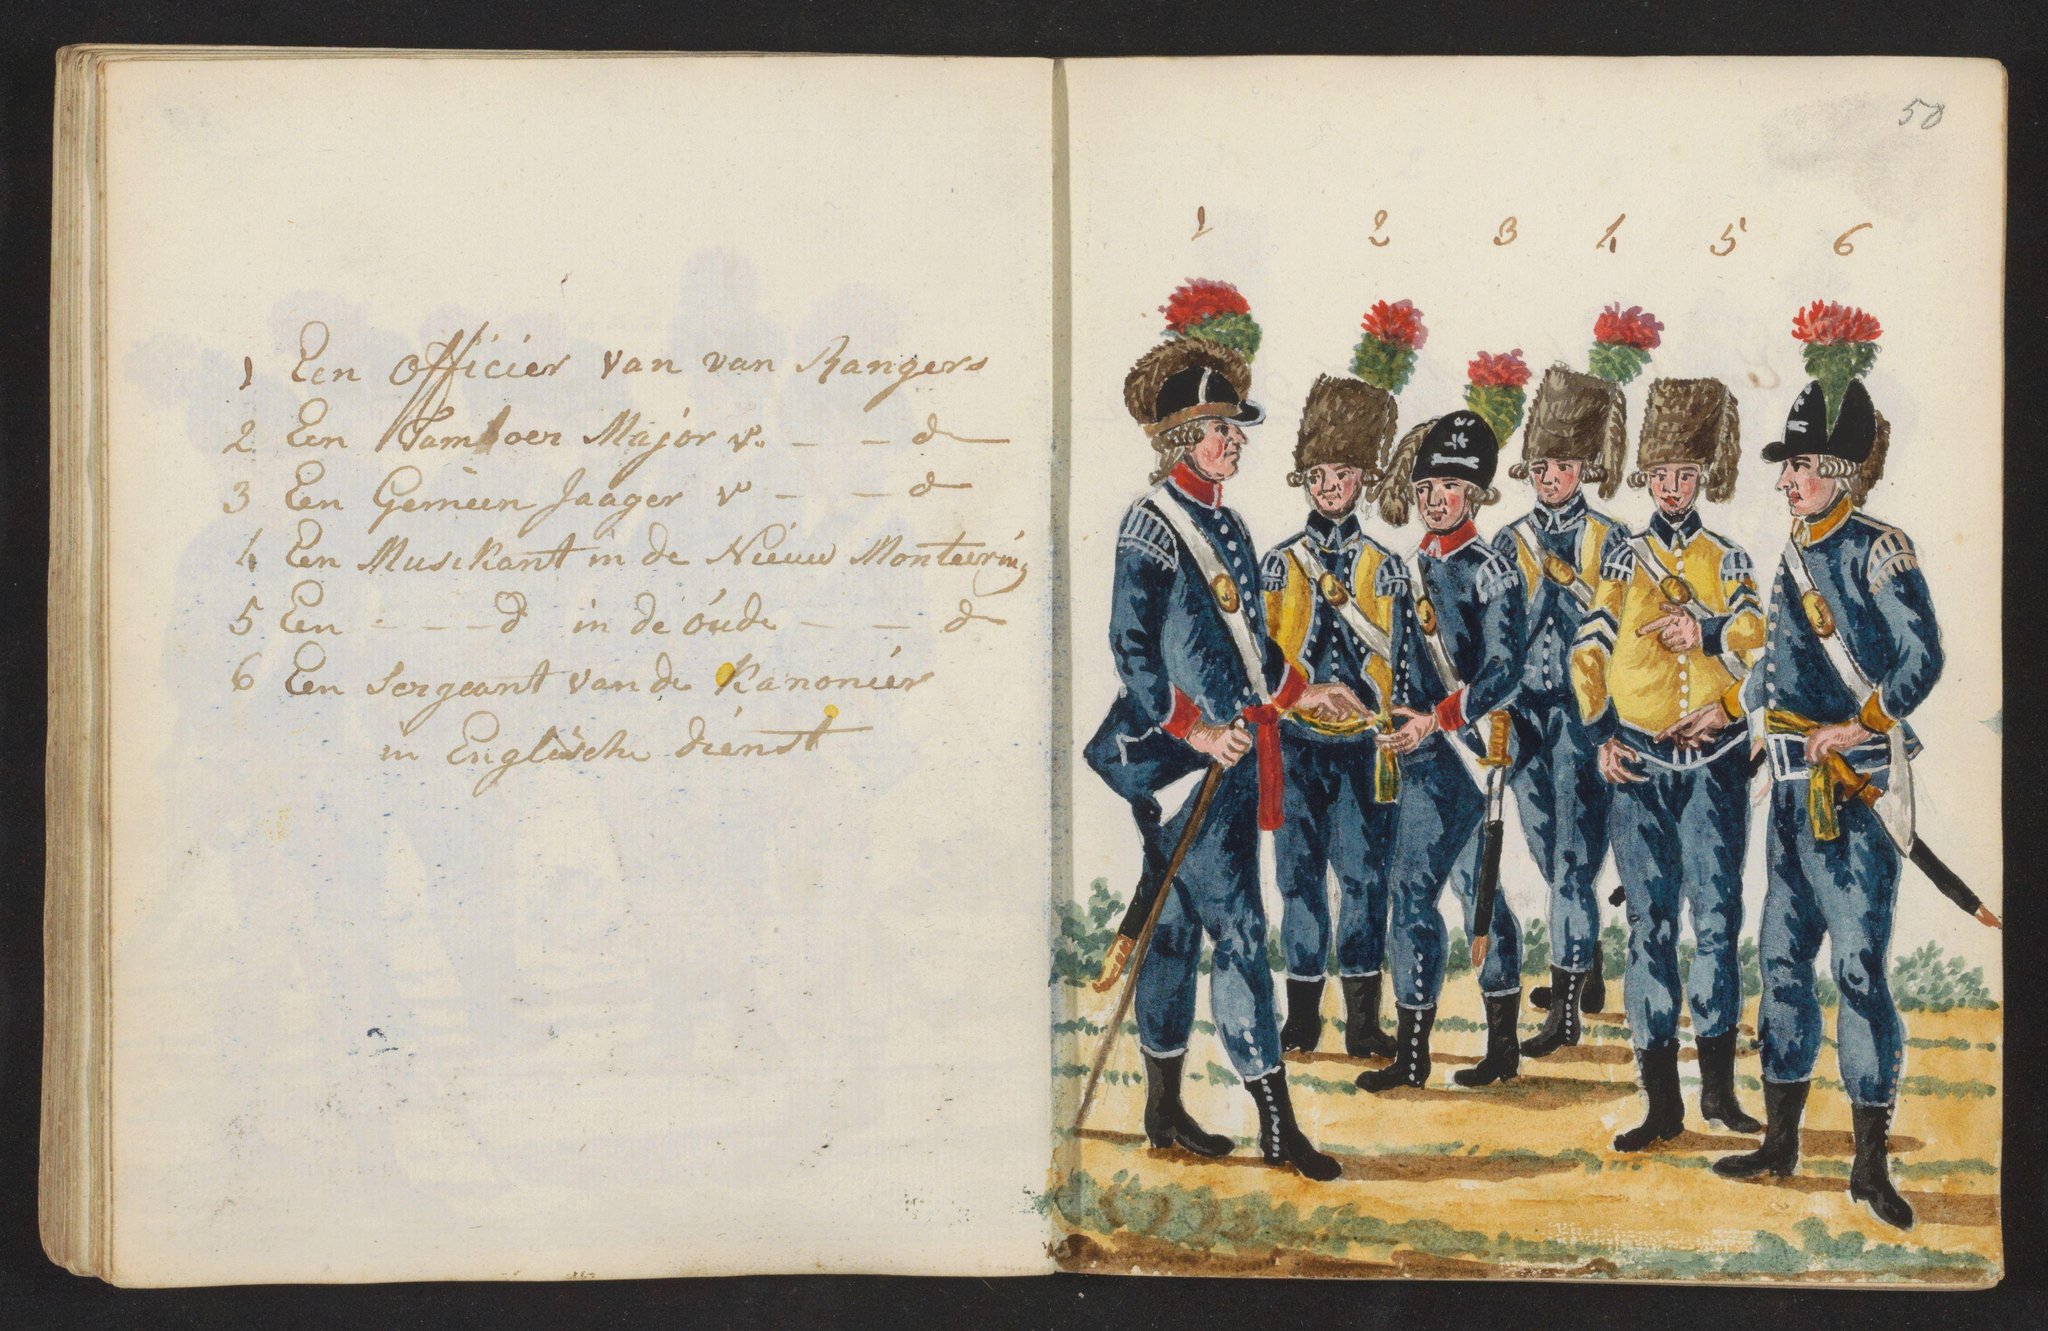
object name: drawing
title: Verschillende uniformen van Engelse Rangers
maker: s.g. casten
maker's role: draughtsman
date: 1795-1796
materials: paper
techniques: writing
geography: amsterdam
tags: (military) uniforms (+ cavalry, horsemen), patriots (1780-1795)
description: Zes uniformen van een Engels regiment Rangers, ca. 1788-1795. Officier, tamboer majoor, jager, muzikanten en een sergeant kanonnier in Engelse dienst. Onderdeel van het derde hoofdstuk over de nieuwe uniformen in de periode na het herstel van de prins van Oranje en de komst van de Pruisische troepen in Holland in 1787. In het schetsboek met gekleurde tekeningen van de uniformen van militairen en leden van de schutterij uit de periode 1770 tot 1795-1796.